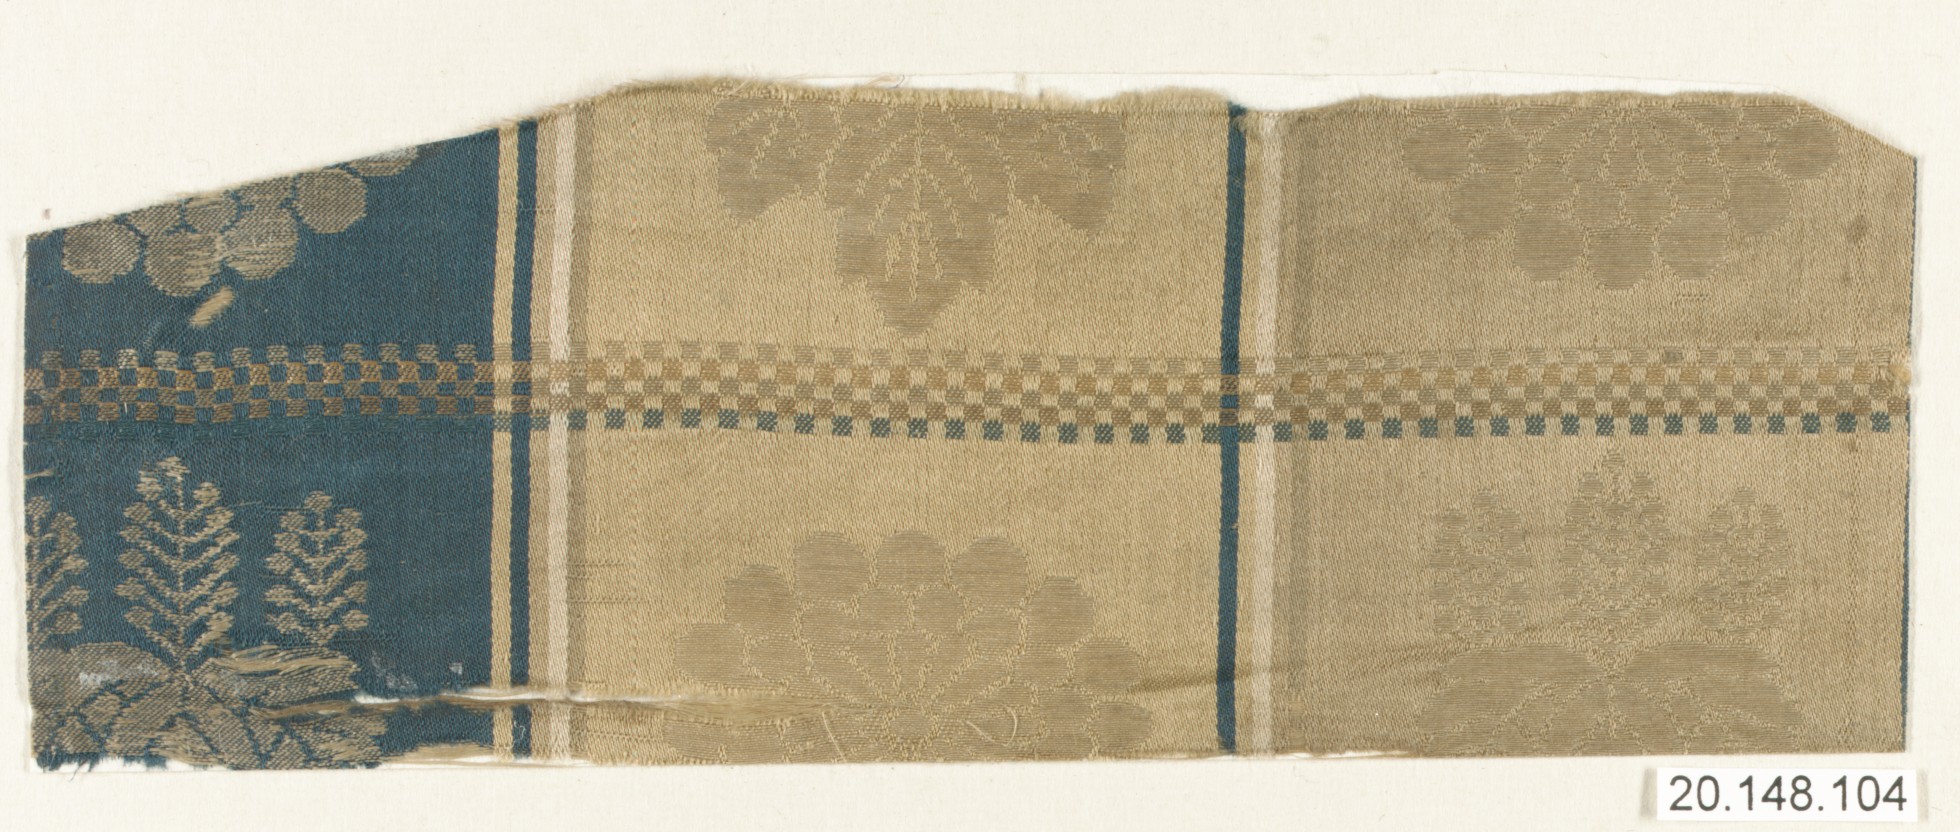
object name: piece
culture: japanese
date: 1601-1700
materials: silk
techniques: compound weave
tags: flowers,leaves